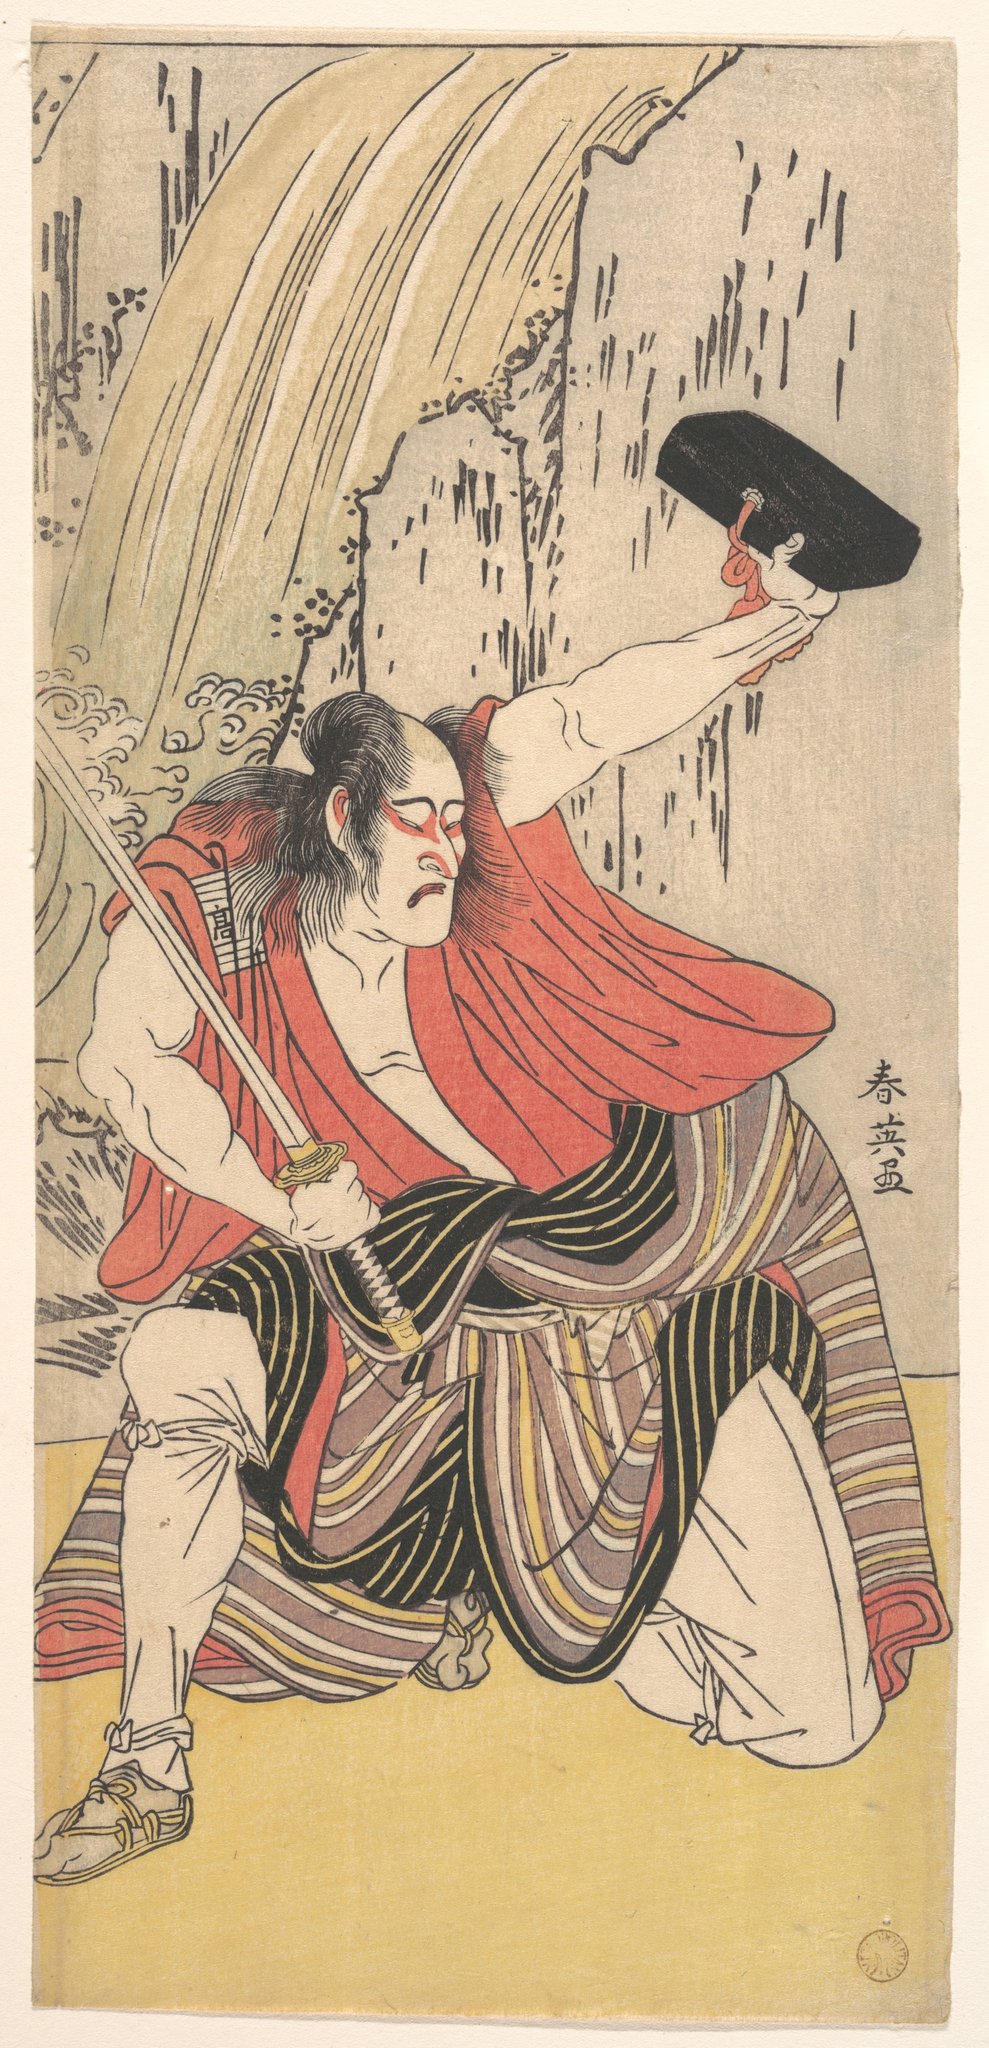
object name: print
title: The Actor Ichikawa Komazo II as a Man Armed with a Sword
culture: japanese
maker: katsukawa shun'ei 勝川春英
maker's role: artist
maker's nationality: japanese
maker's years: 1762-1819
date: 1789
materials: ink, paper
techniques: woodblock print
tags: swords,men,actors